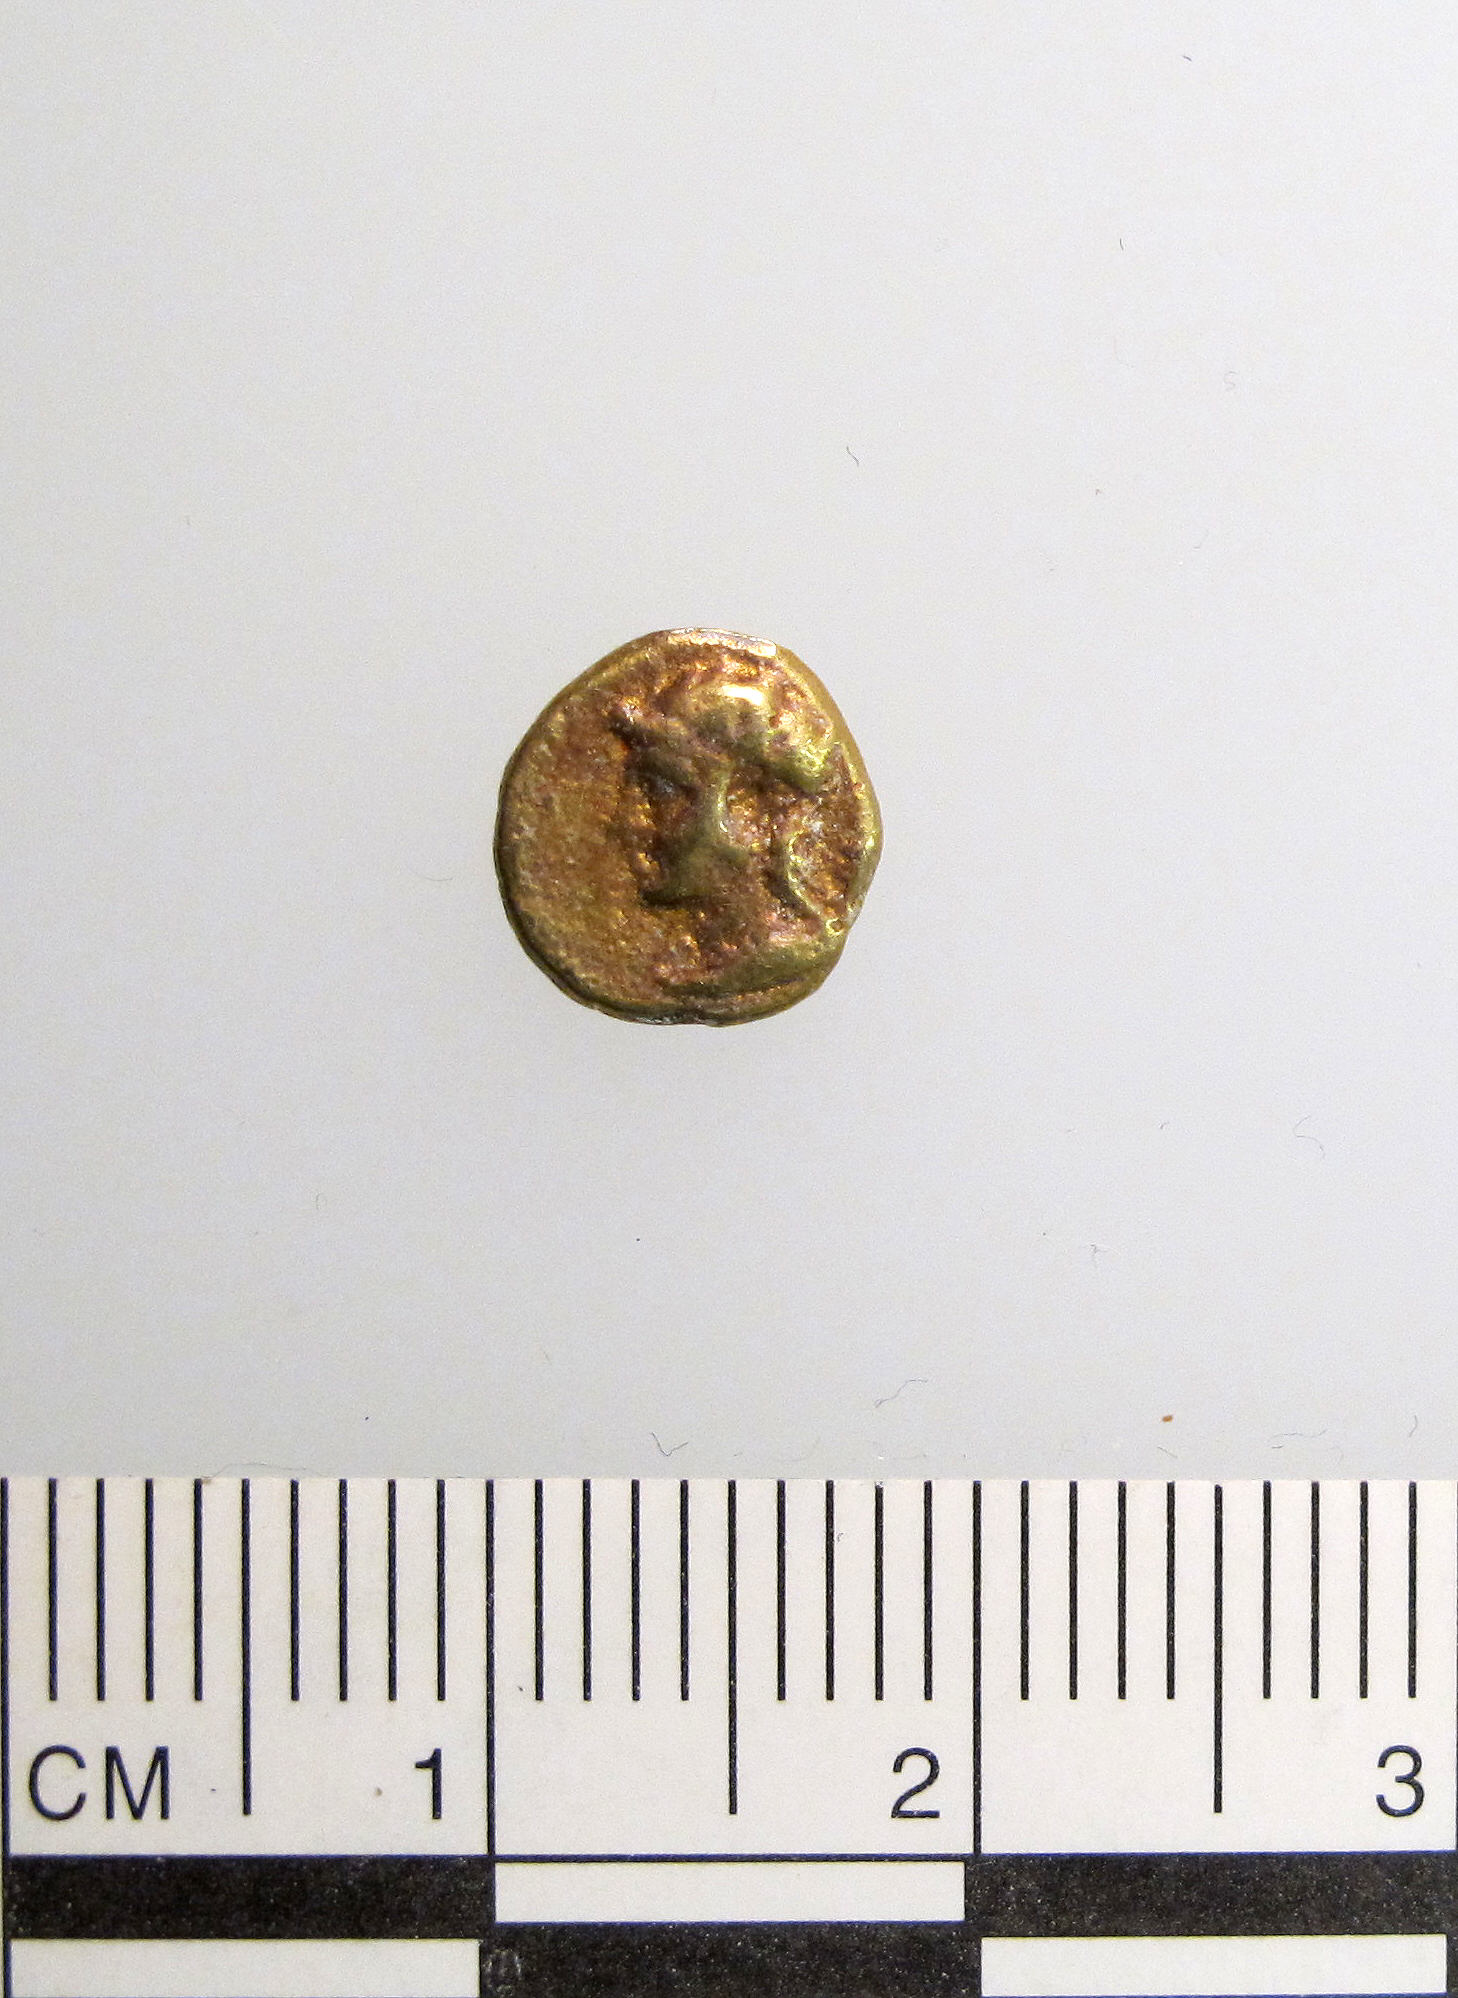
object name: coin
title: Gold coin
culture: cypriot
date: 312-306 BCE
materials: gold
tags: aphrodite